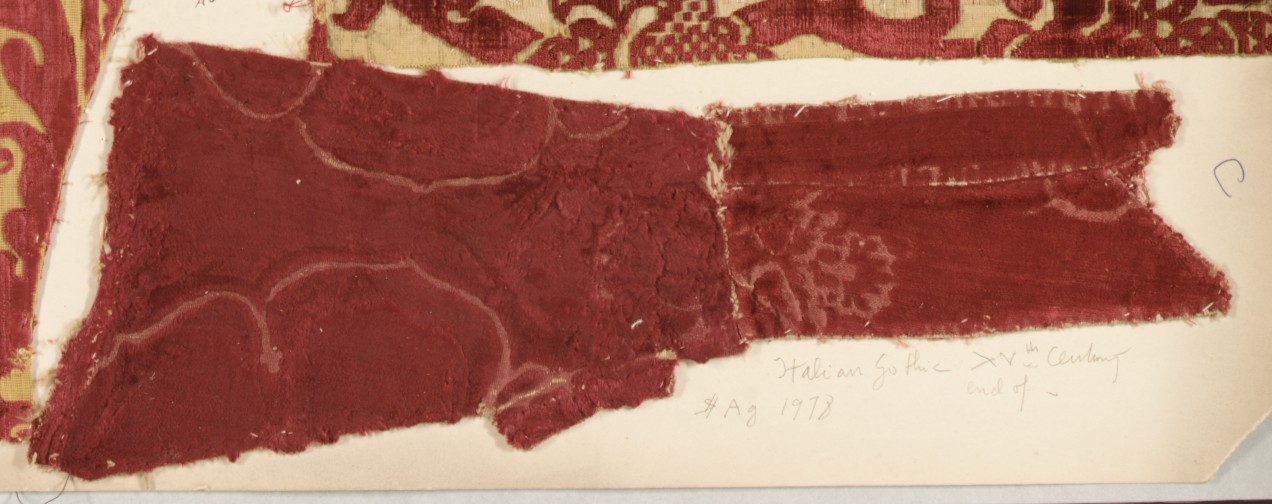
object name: fragment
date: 1467-1500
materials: silk